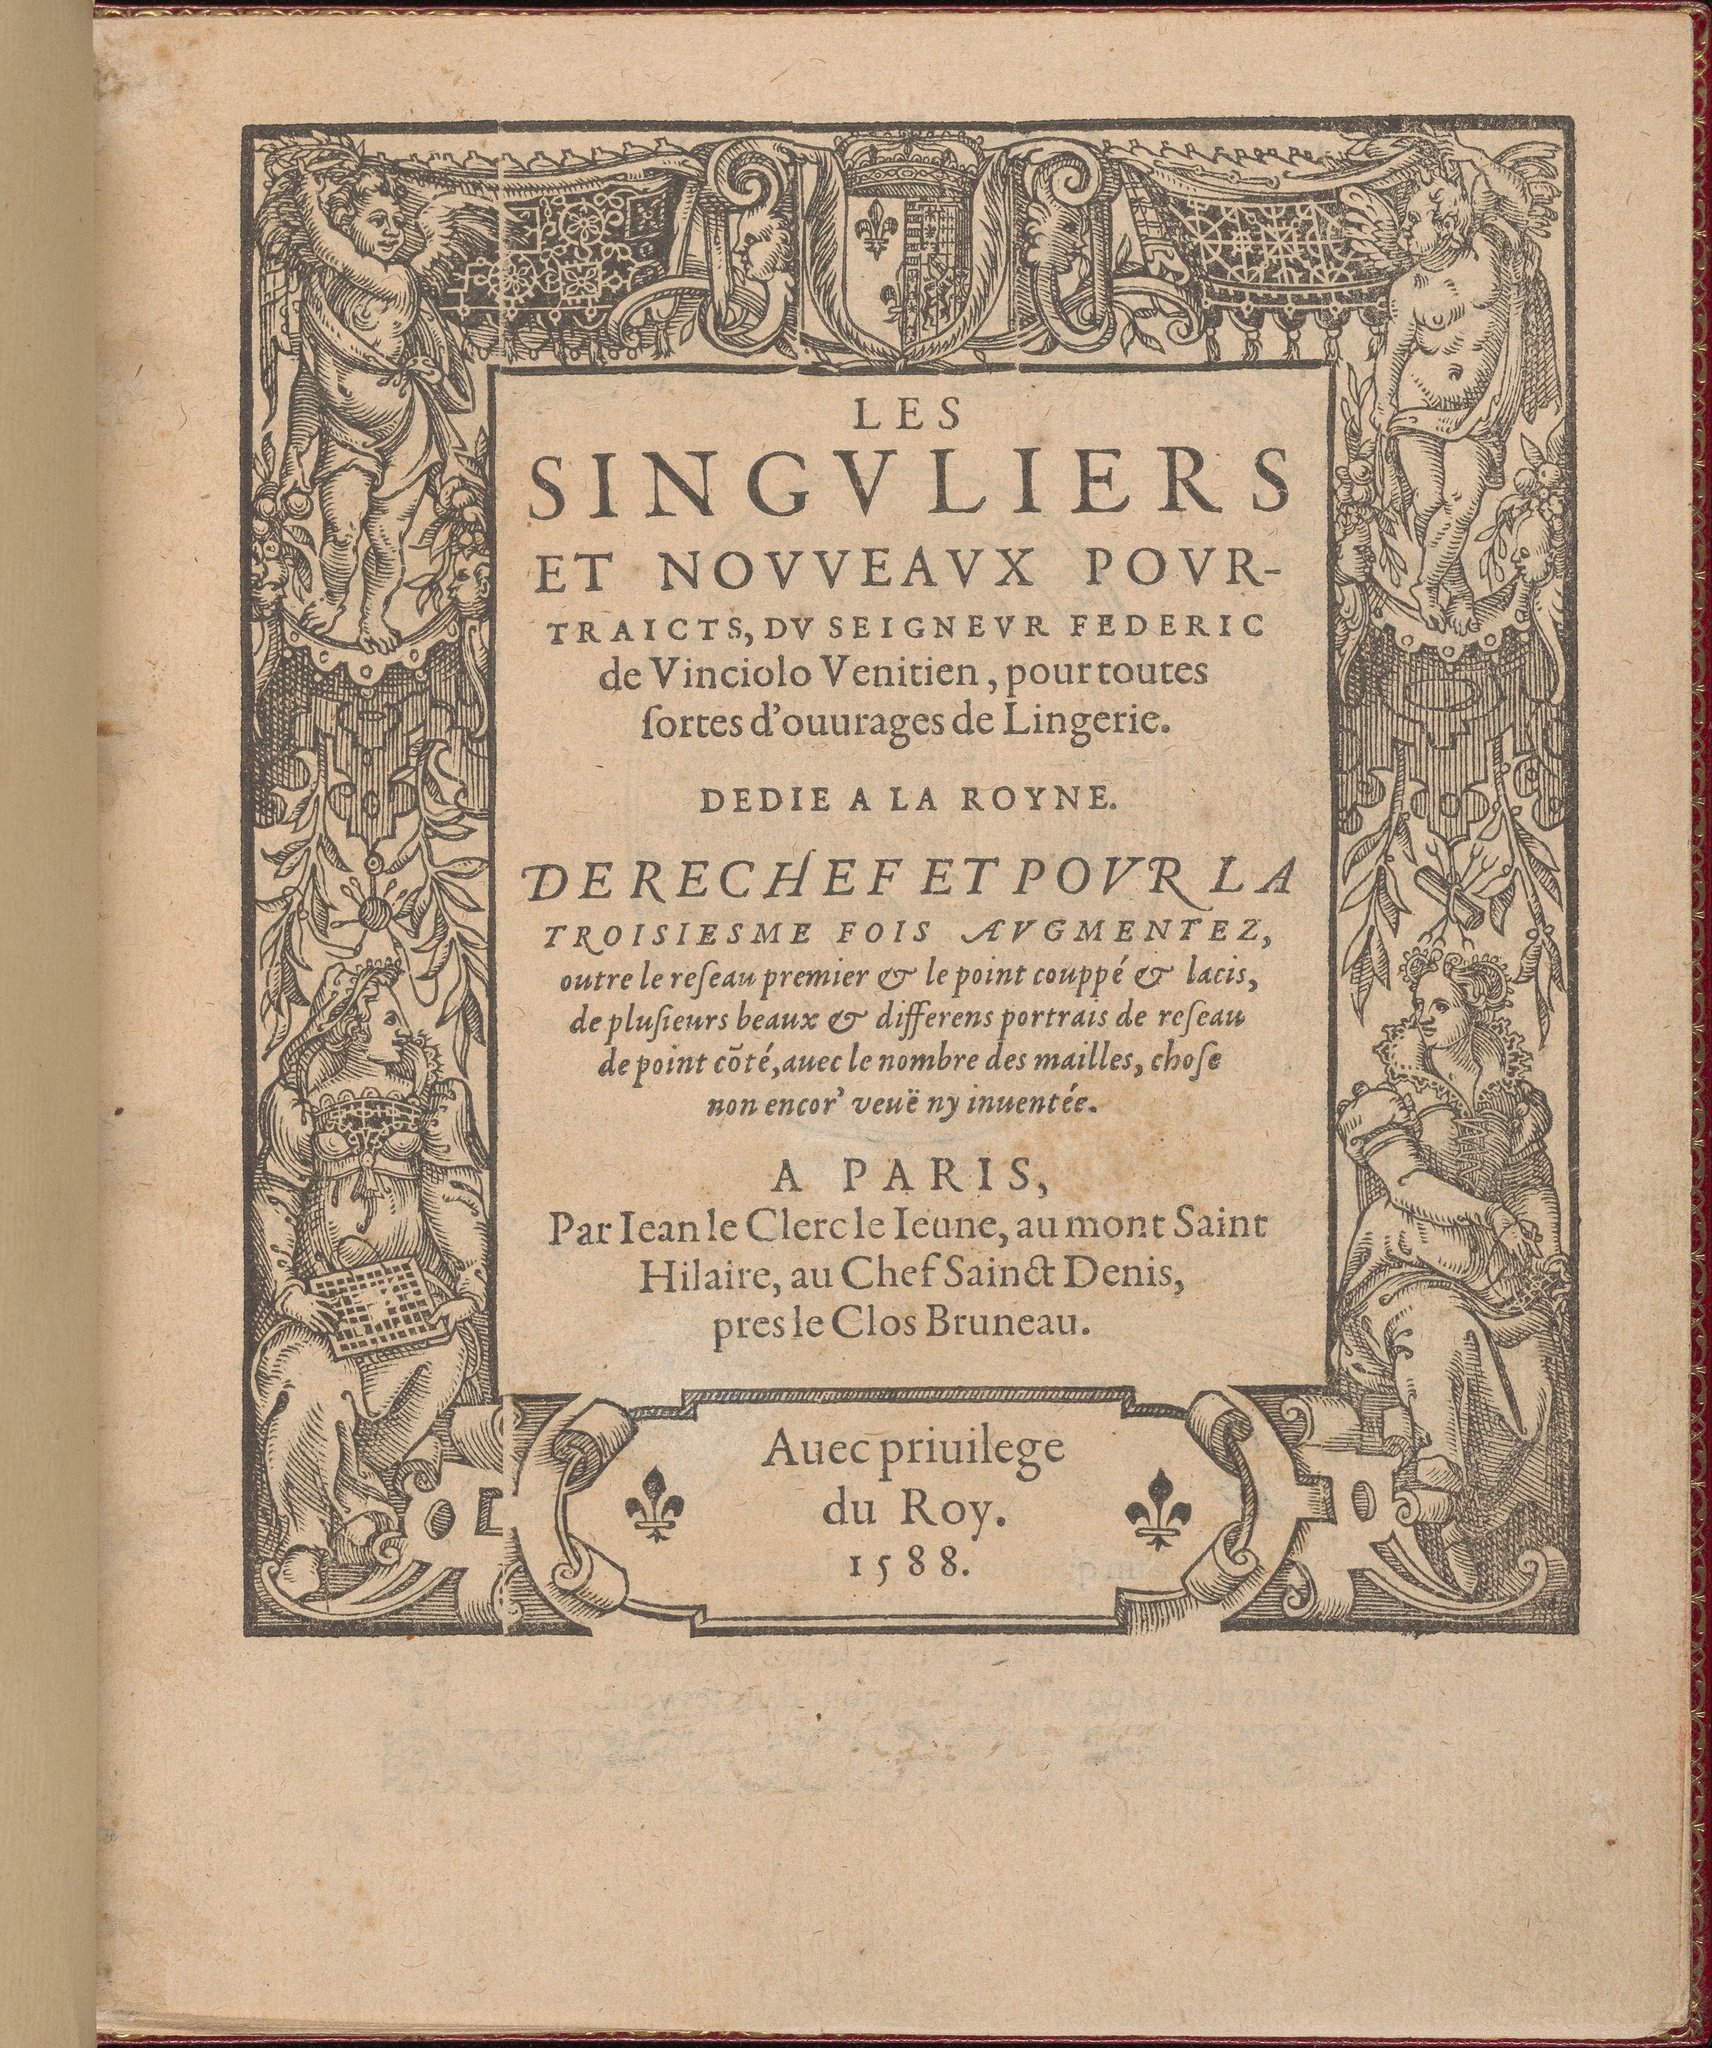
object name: book print ornament architecture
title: Les Singuliers et Nouveaux Portraicts... Part I title page (recto)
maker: federico de vinciolo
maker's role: designer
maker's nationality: italian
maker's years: 1582-1599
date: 1588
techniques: woodcut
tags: women,putti,coat of arms,sewing